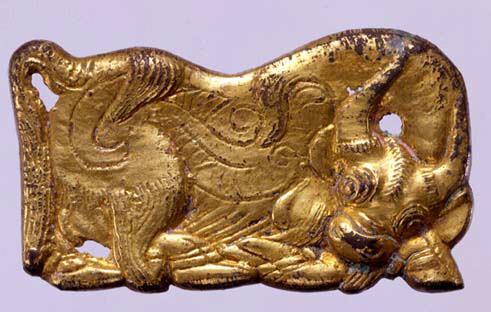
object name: belt buckle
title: Belt Buckle with Bovine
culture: north chinese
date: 300-101 BCE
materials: bronze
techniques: gilding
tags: animals